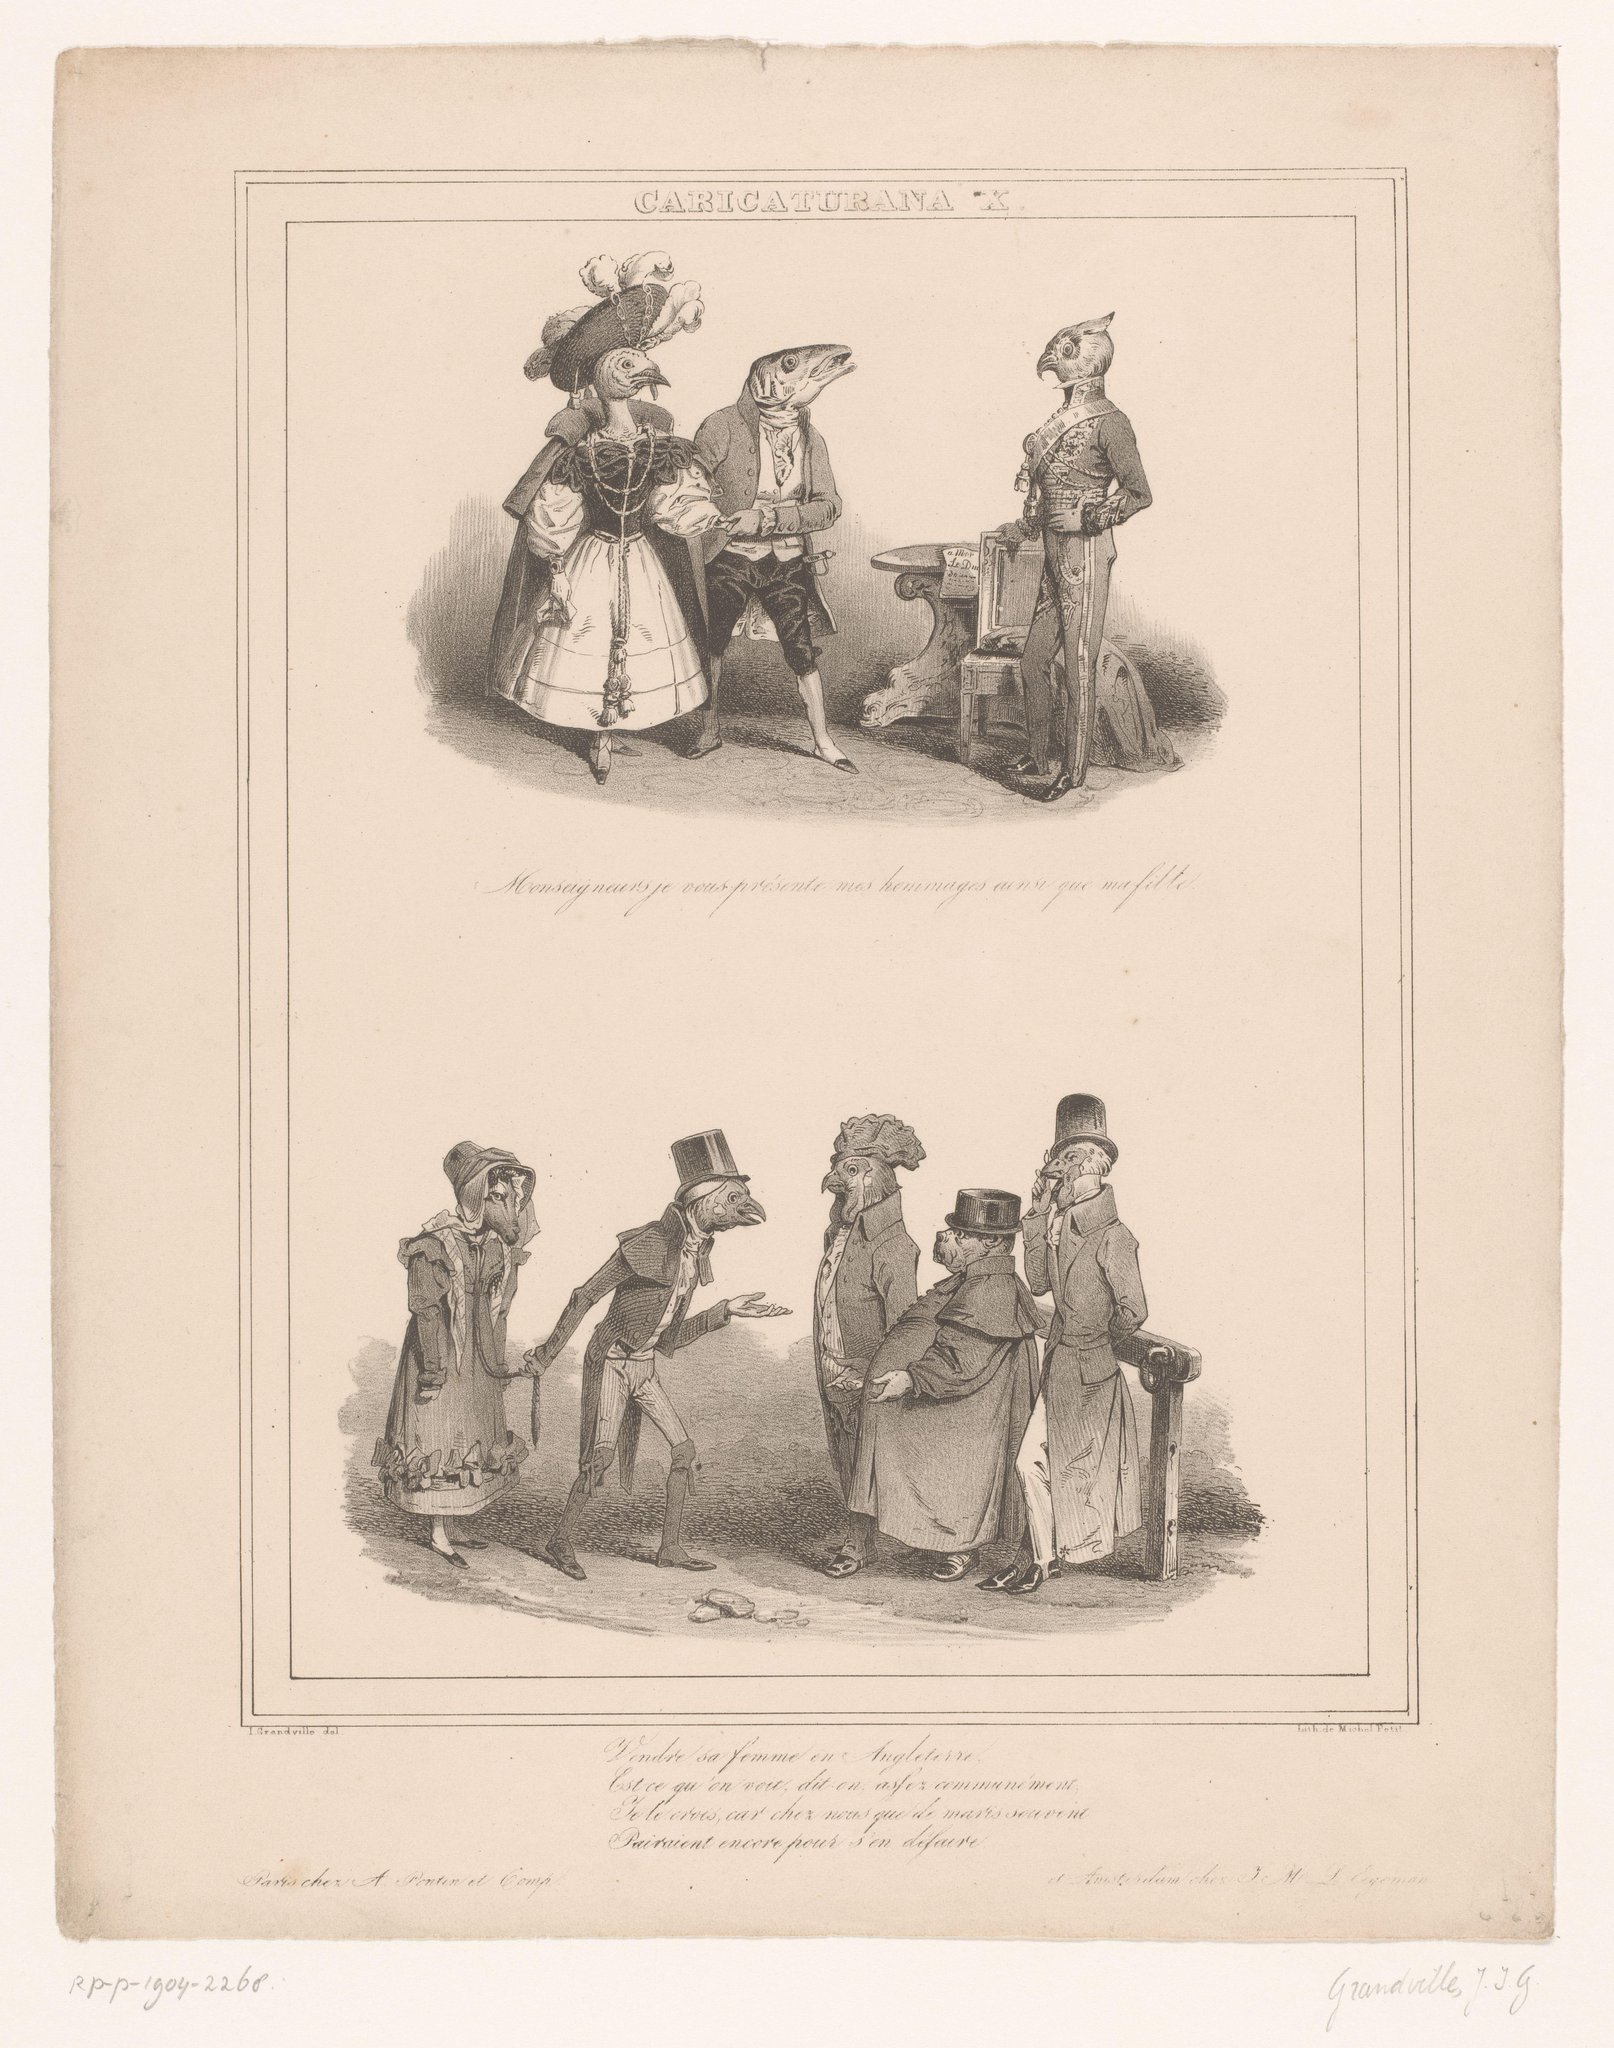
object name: cartoon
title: Man met vogelkop wil zijn vrouw verkopen in Engeland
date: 1828-1829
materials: paper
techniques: lithograph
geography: amsterdam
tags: animals acting as human beings, animals (+ animals in caricature)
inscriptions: collector's mark: Lugt 2228a